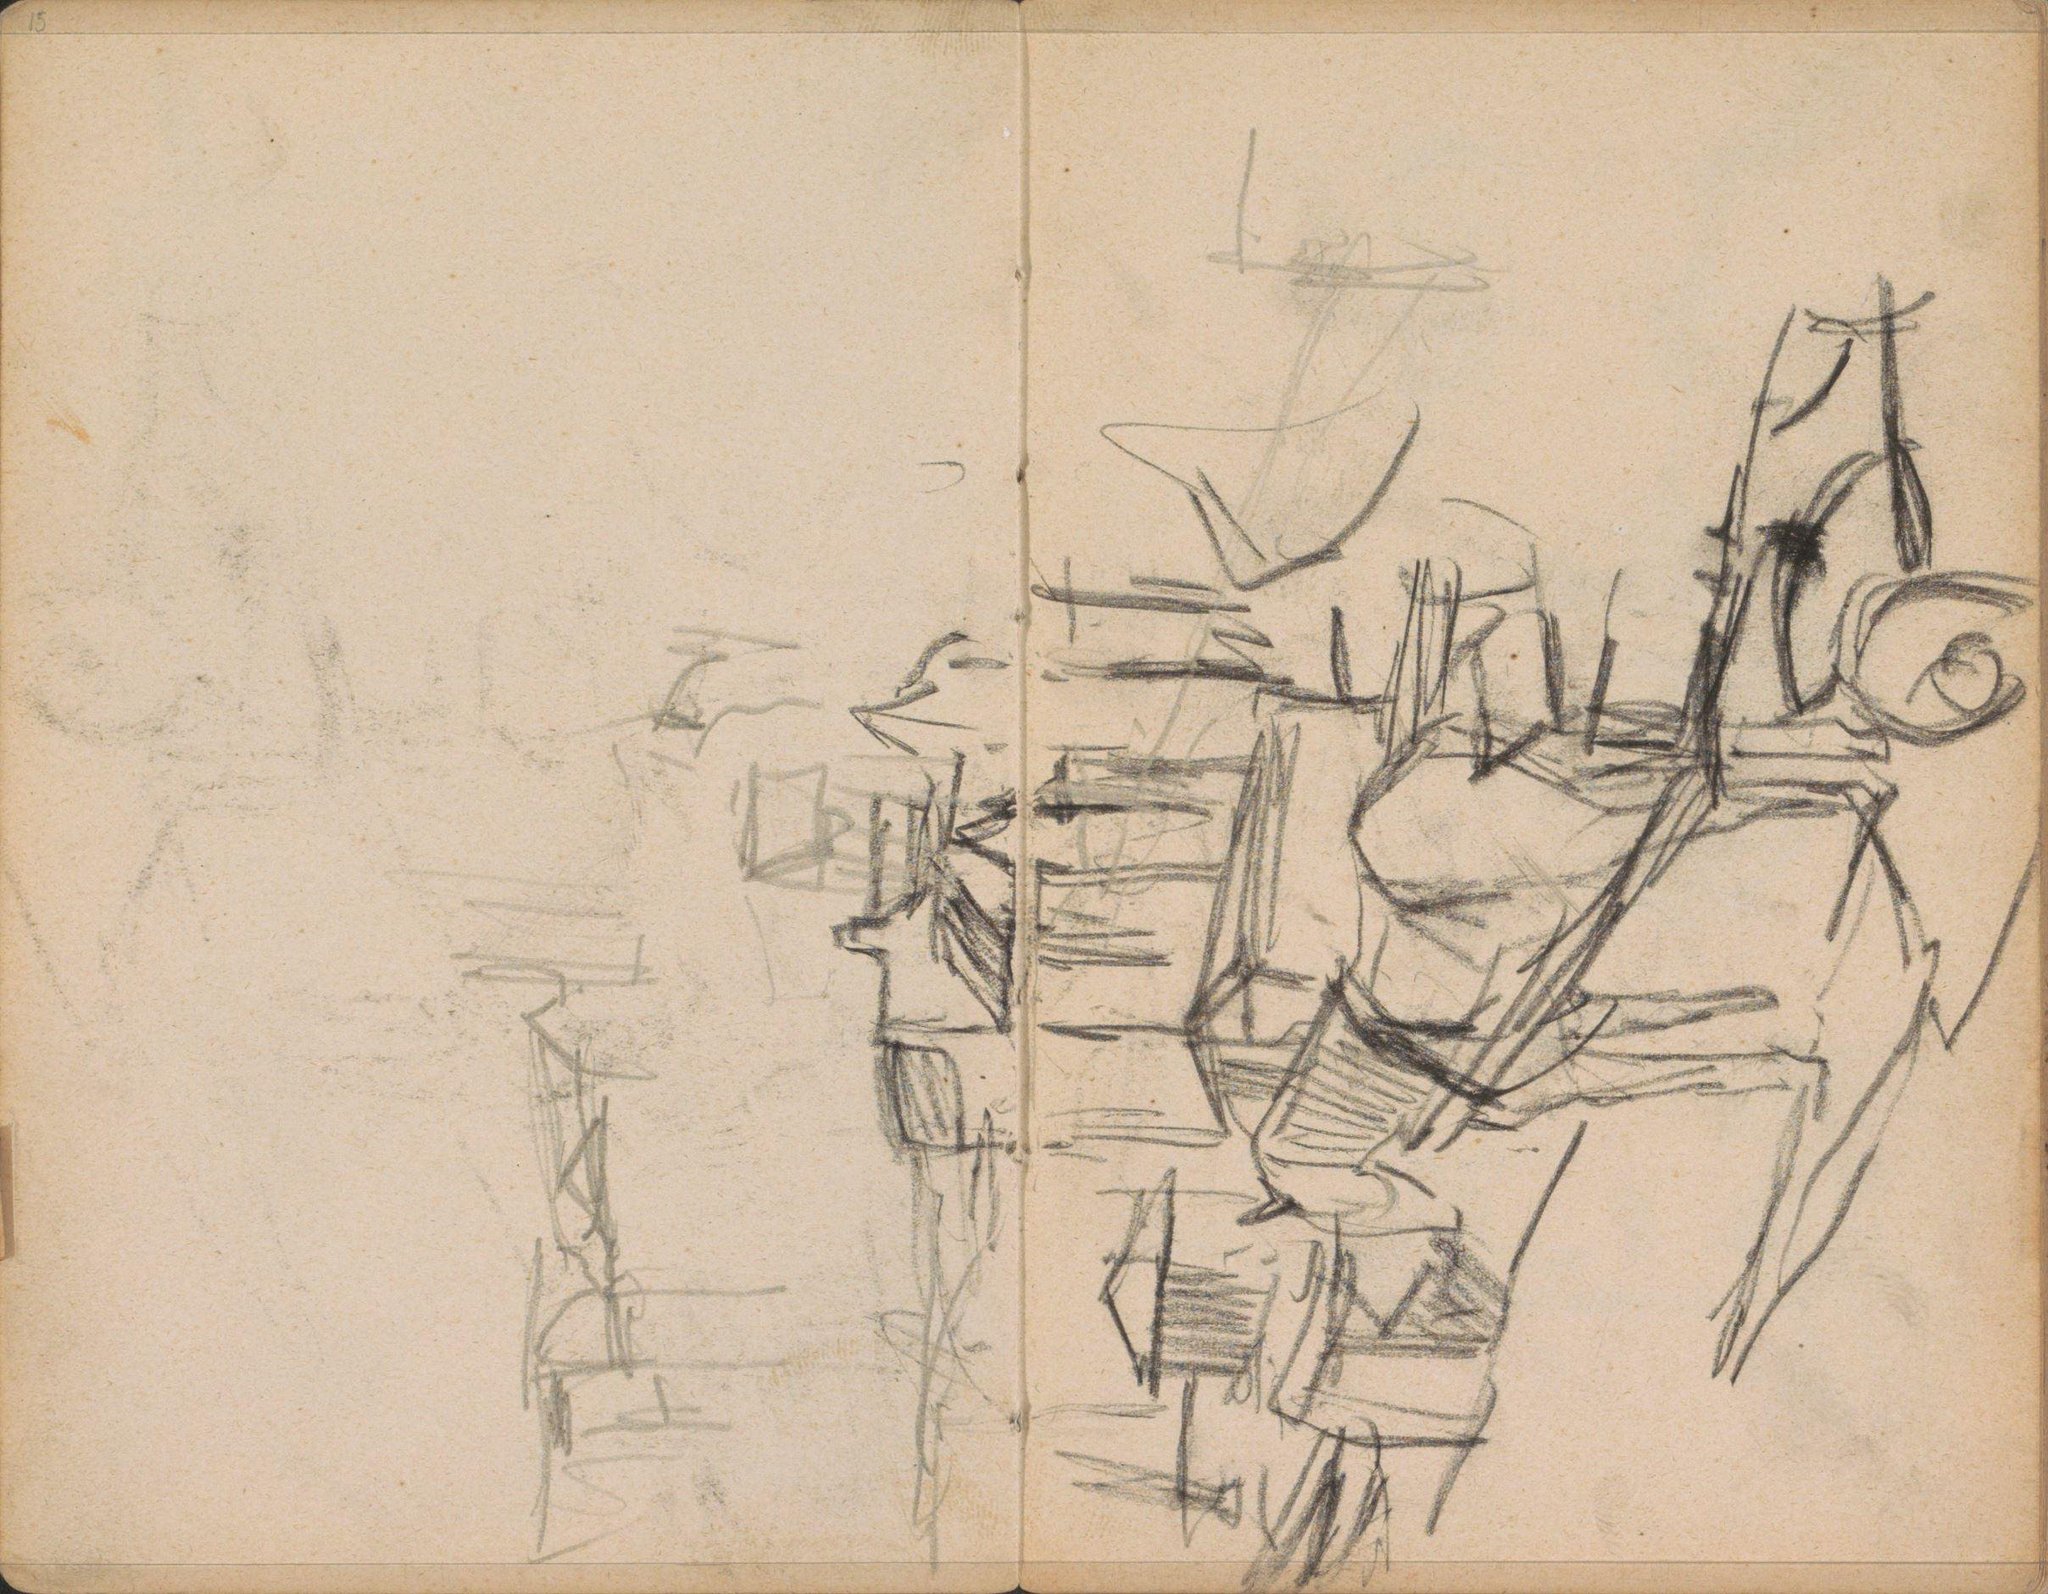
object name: sketchbook leaf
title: Gezicht in Amsterdam en een paardenkar voor gebouwen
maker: george hendrik breitner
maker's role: draughtsman, painter, print maker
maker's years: 1857-1923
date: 1886-1908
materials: chalk, paper, pencil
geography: amsterdam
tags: urban housing, horse, street, (farm) wagon, freight wagon, cart, amsterdam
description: Pagina 15 en pagina 16 uit een schetsboek met 46 bladen vervaardigd te Amsterdam, Haarlem en Antwerpen.